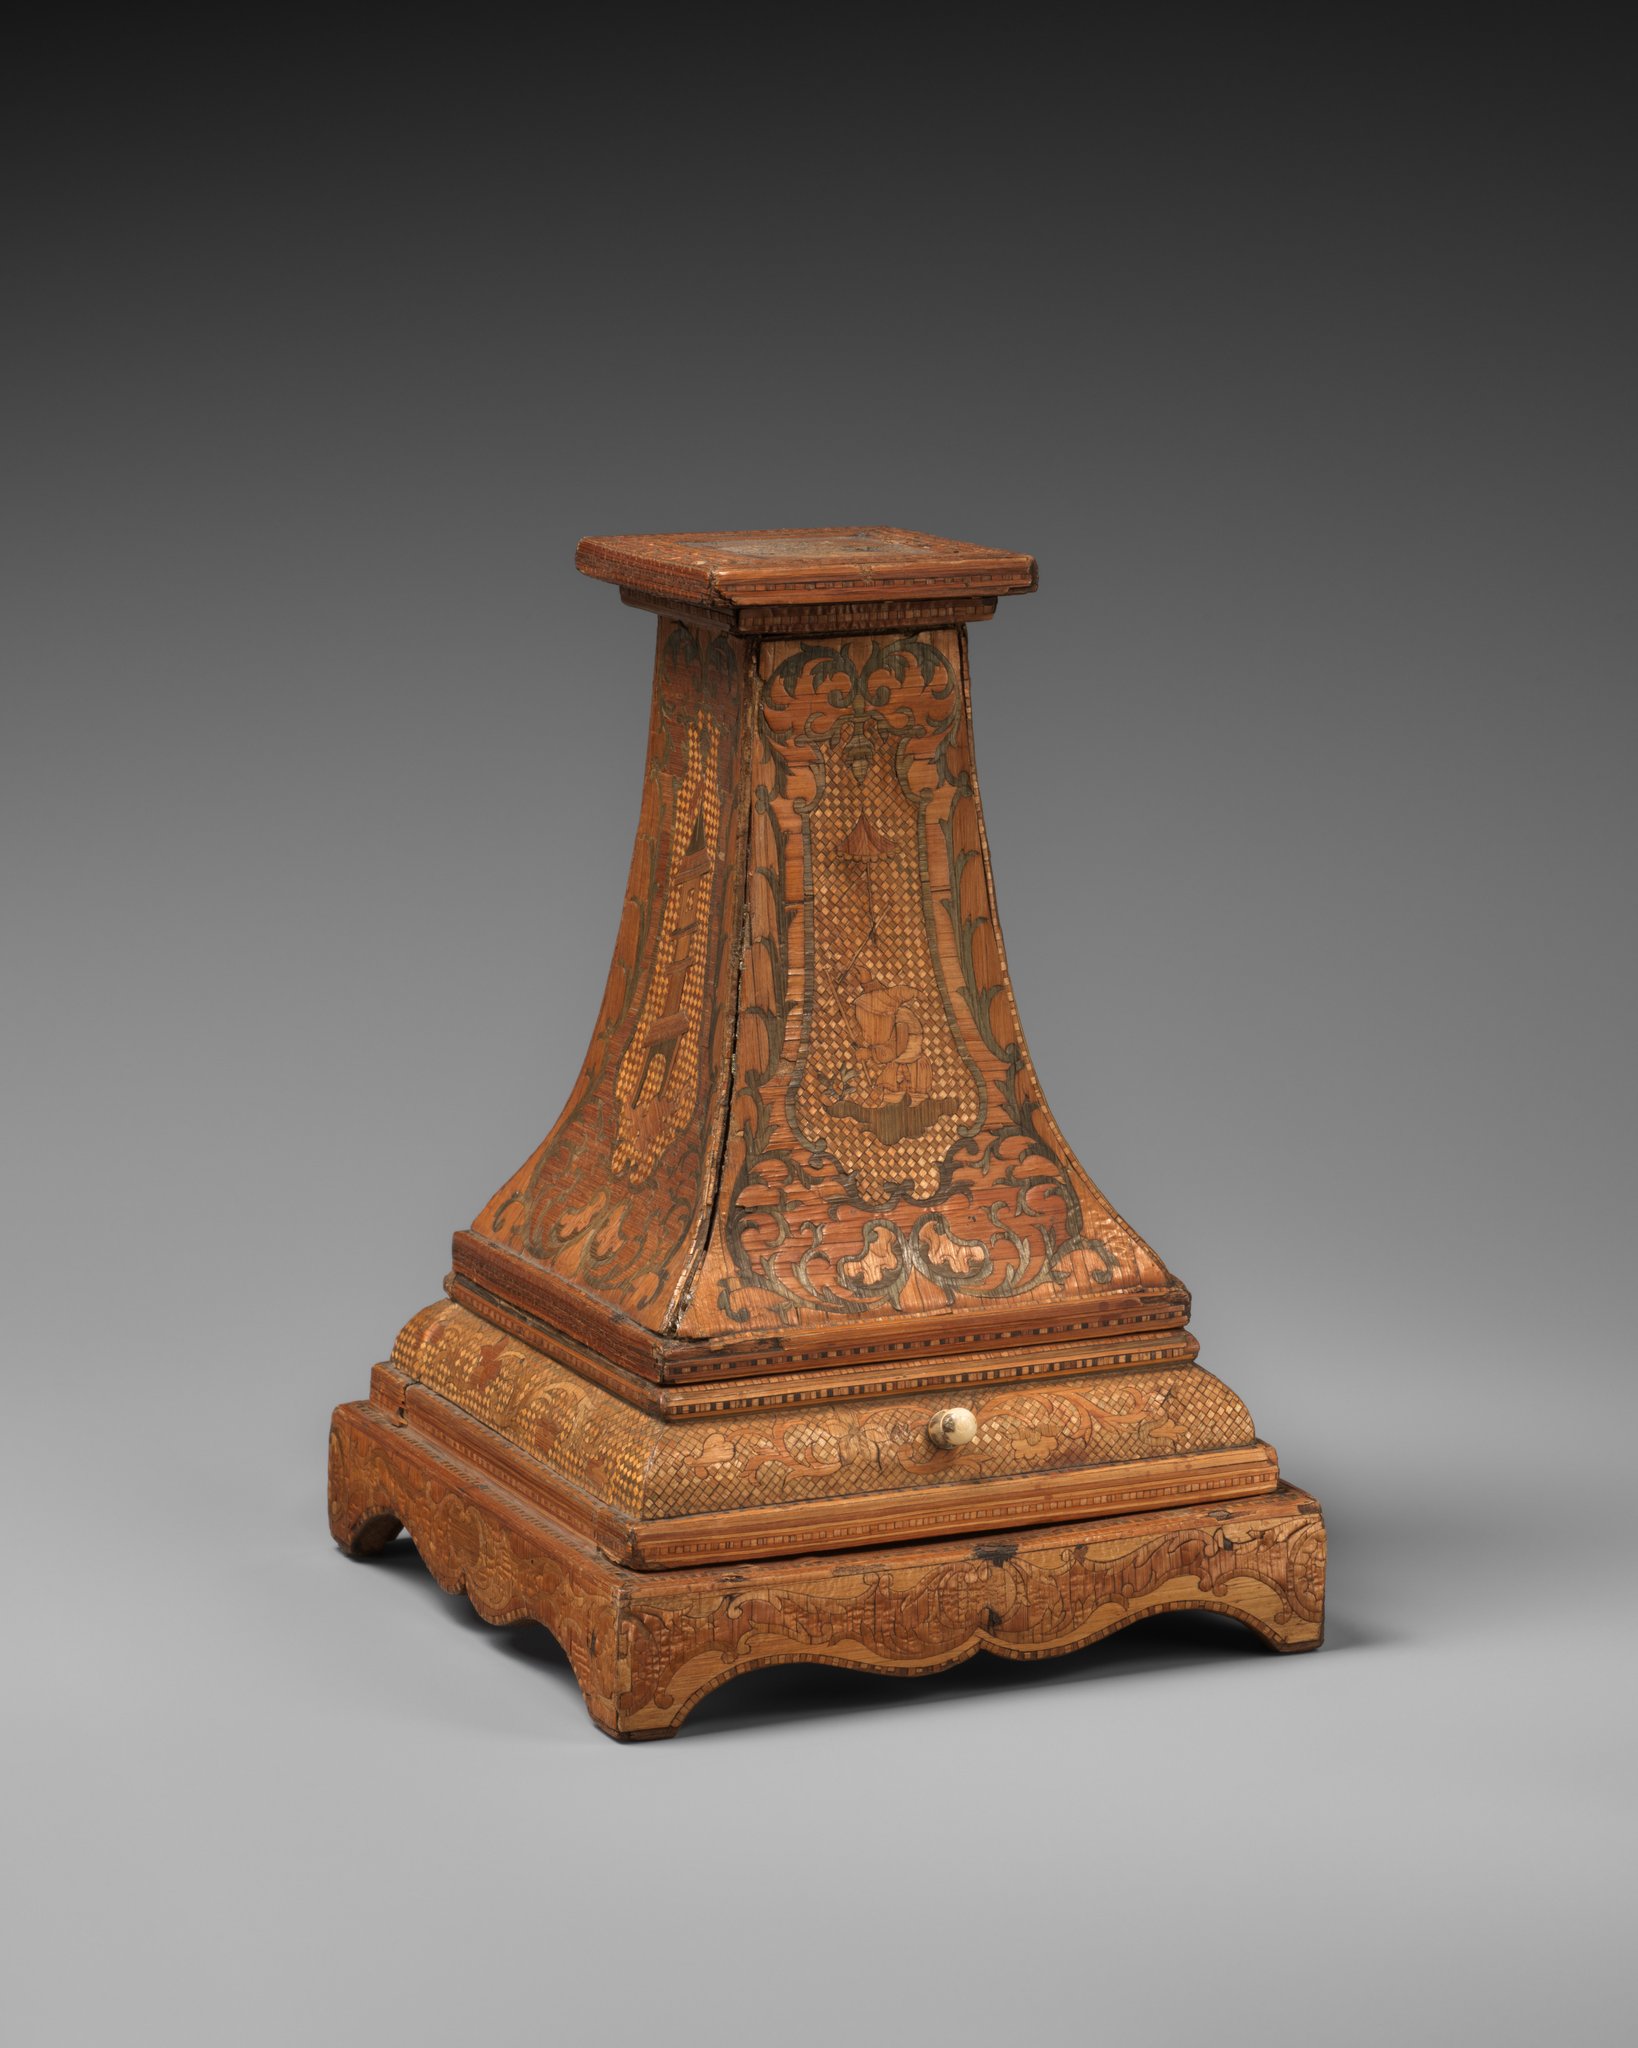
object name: pedestal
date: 1701-1750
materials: ivory, fiber, wood